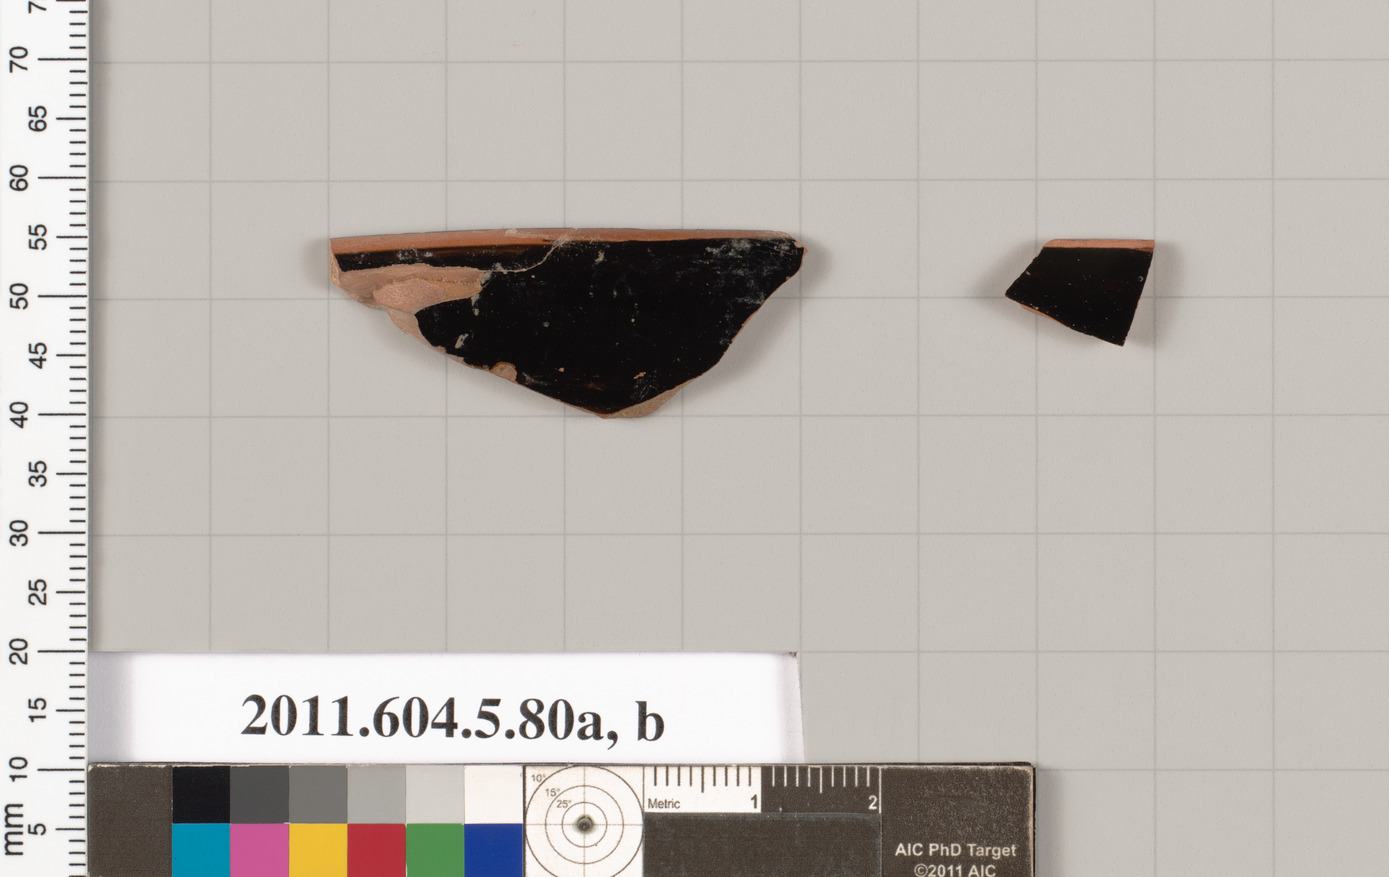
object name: kylix fragment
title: Terracotta rim fragments of kylikes (drinking cups)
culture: greek, attic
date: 520-480 BCE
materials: terracotta